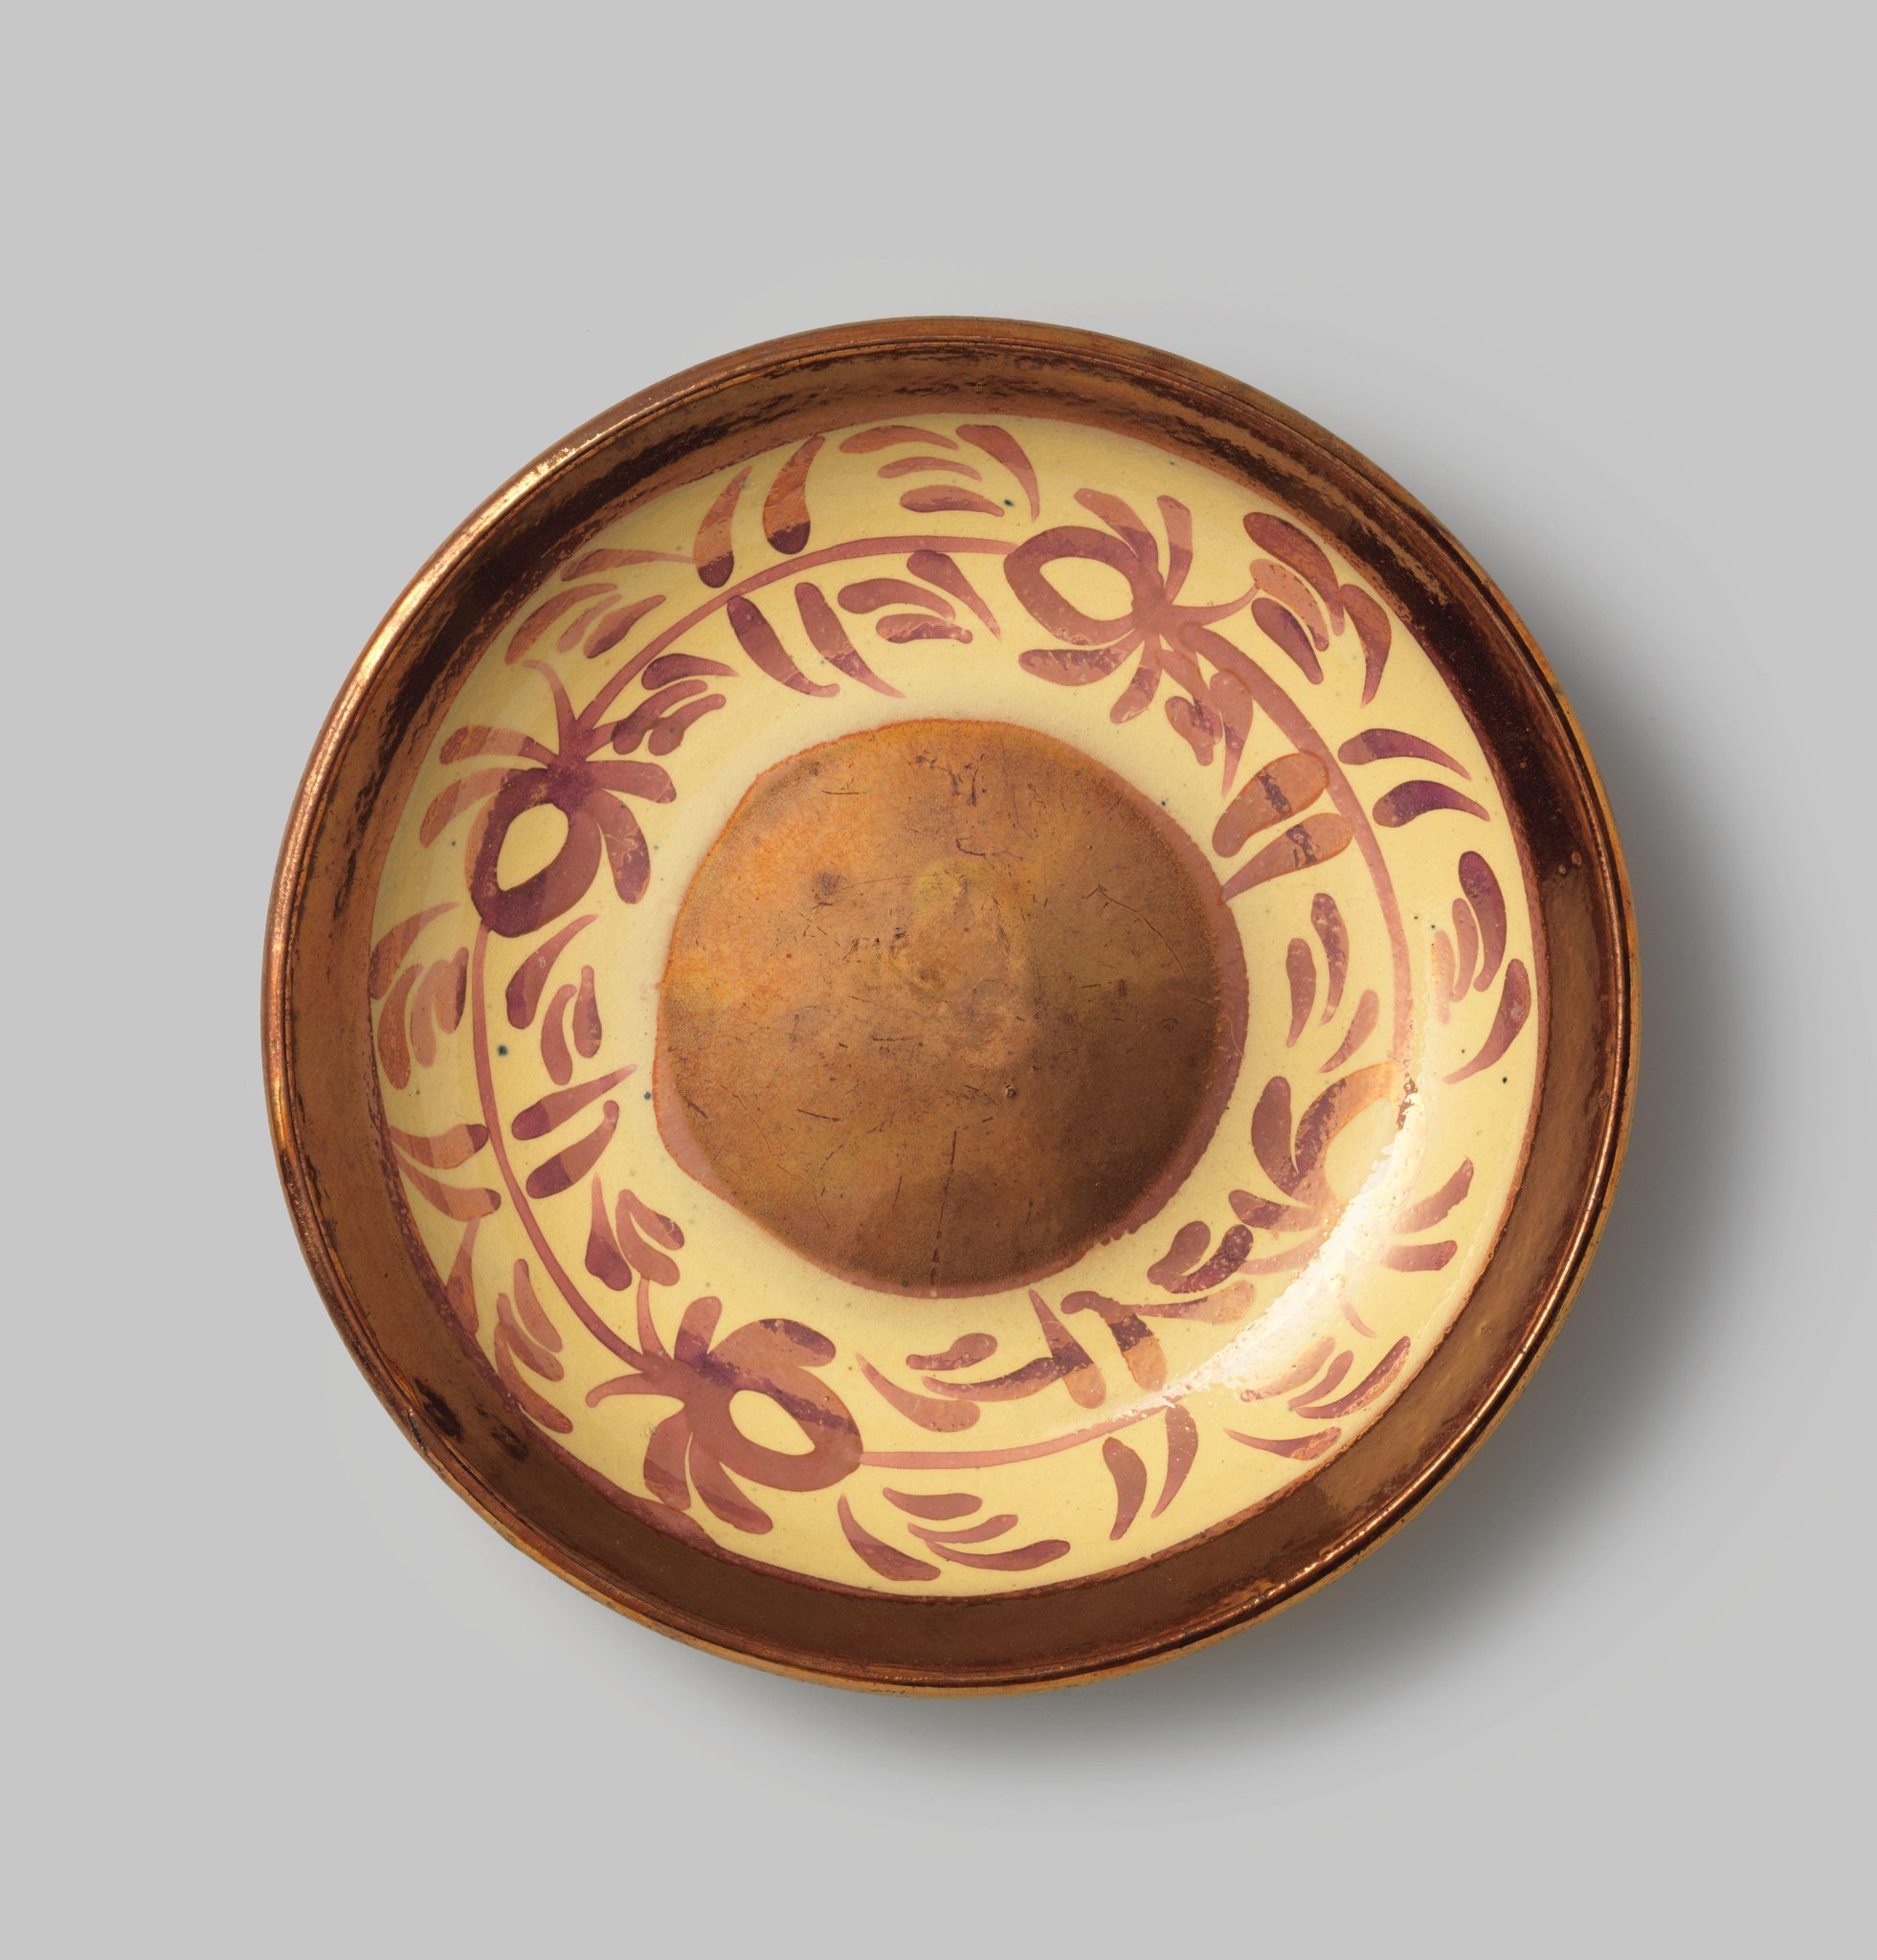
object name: platter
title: Schotel, met op de rand gouden bloemen en bladeren tegen een uitgepaarde, gele grond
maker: petrus regout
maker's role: plateelbakker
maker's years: 1801-1879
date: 1860-1890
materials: stoneware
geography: maastricht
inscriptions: check stamp: ‘PETRUS REGOUT // 6 // MAASTRICHT’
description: Schotel van aardewerk, goudsteen. Op de rand zijn in lilaluster bloemen en bladeren aangebracht tegen een uitgspaarde, gele grond. Het plat en de onderzijde zijn geheel bedekt met lilaluster.